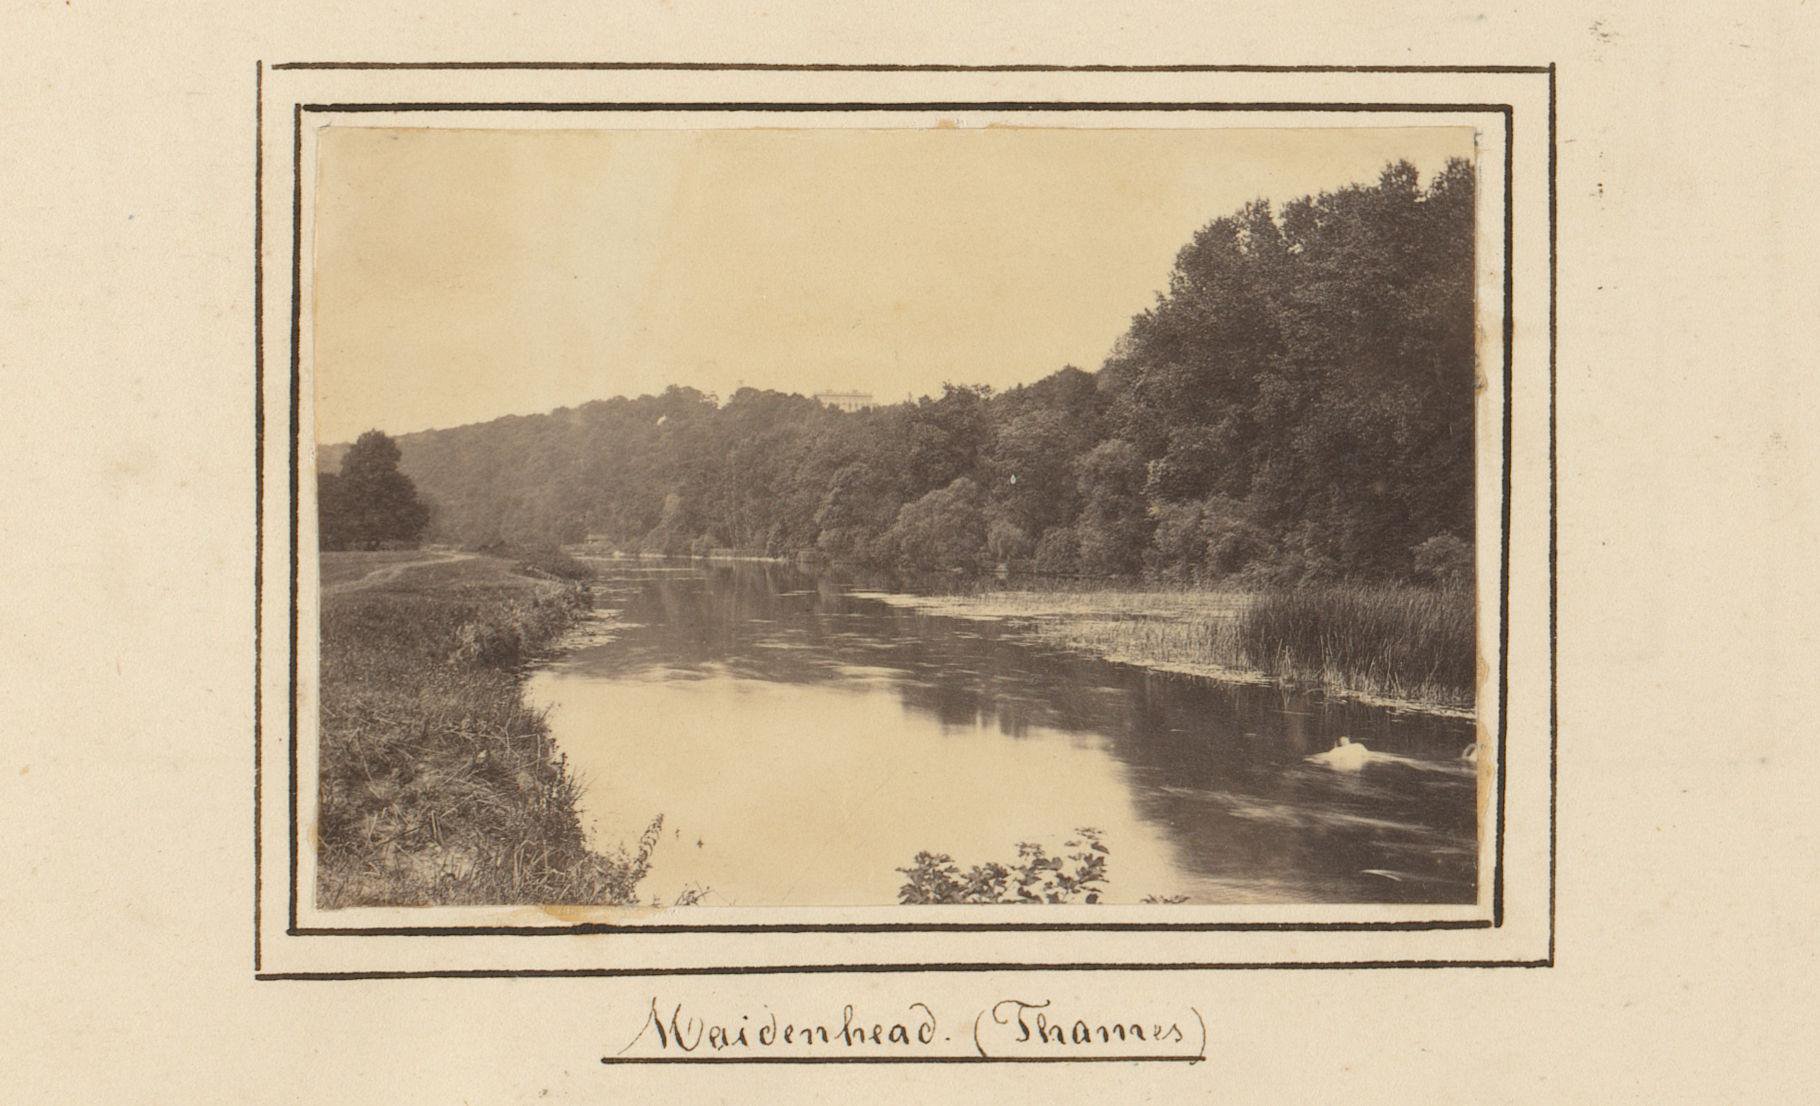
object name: album leaf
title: Theems in Maidenhead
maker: Anonymous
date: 1865-1890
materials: paper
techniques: albumen print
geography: maidenhead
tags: river, thames